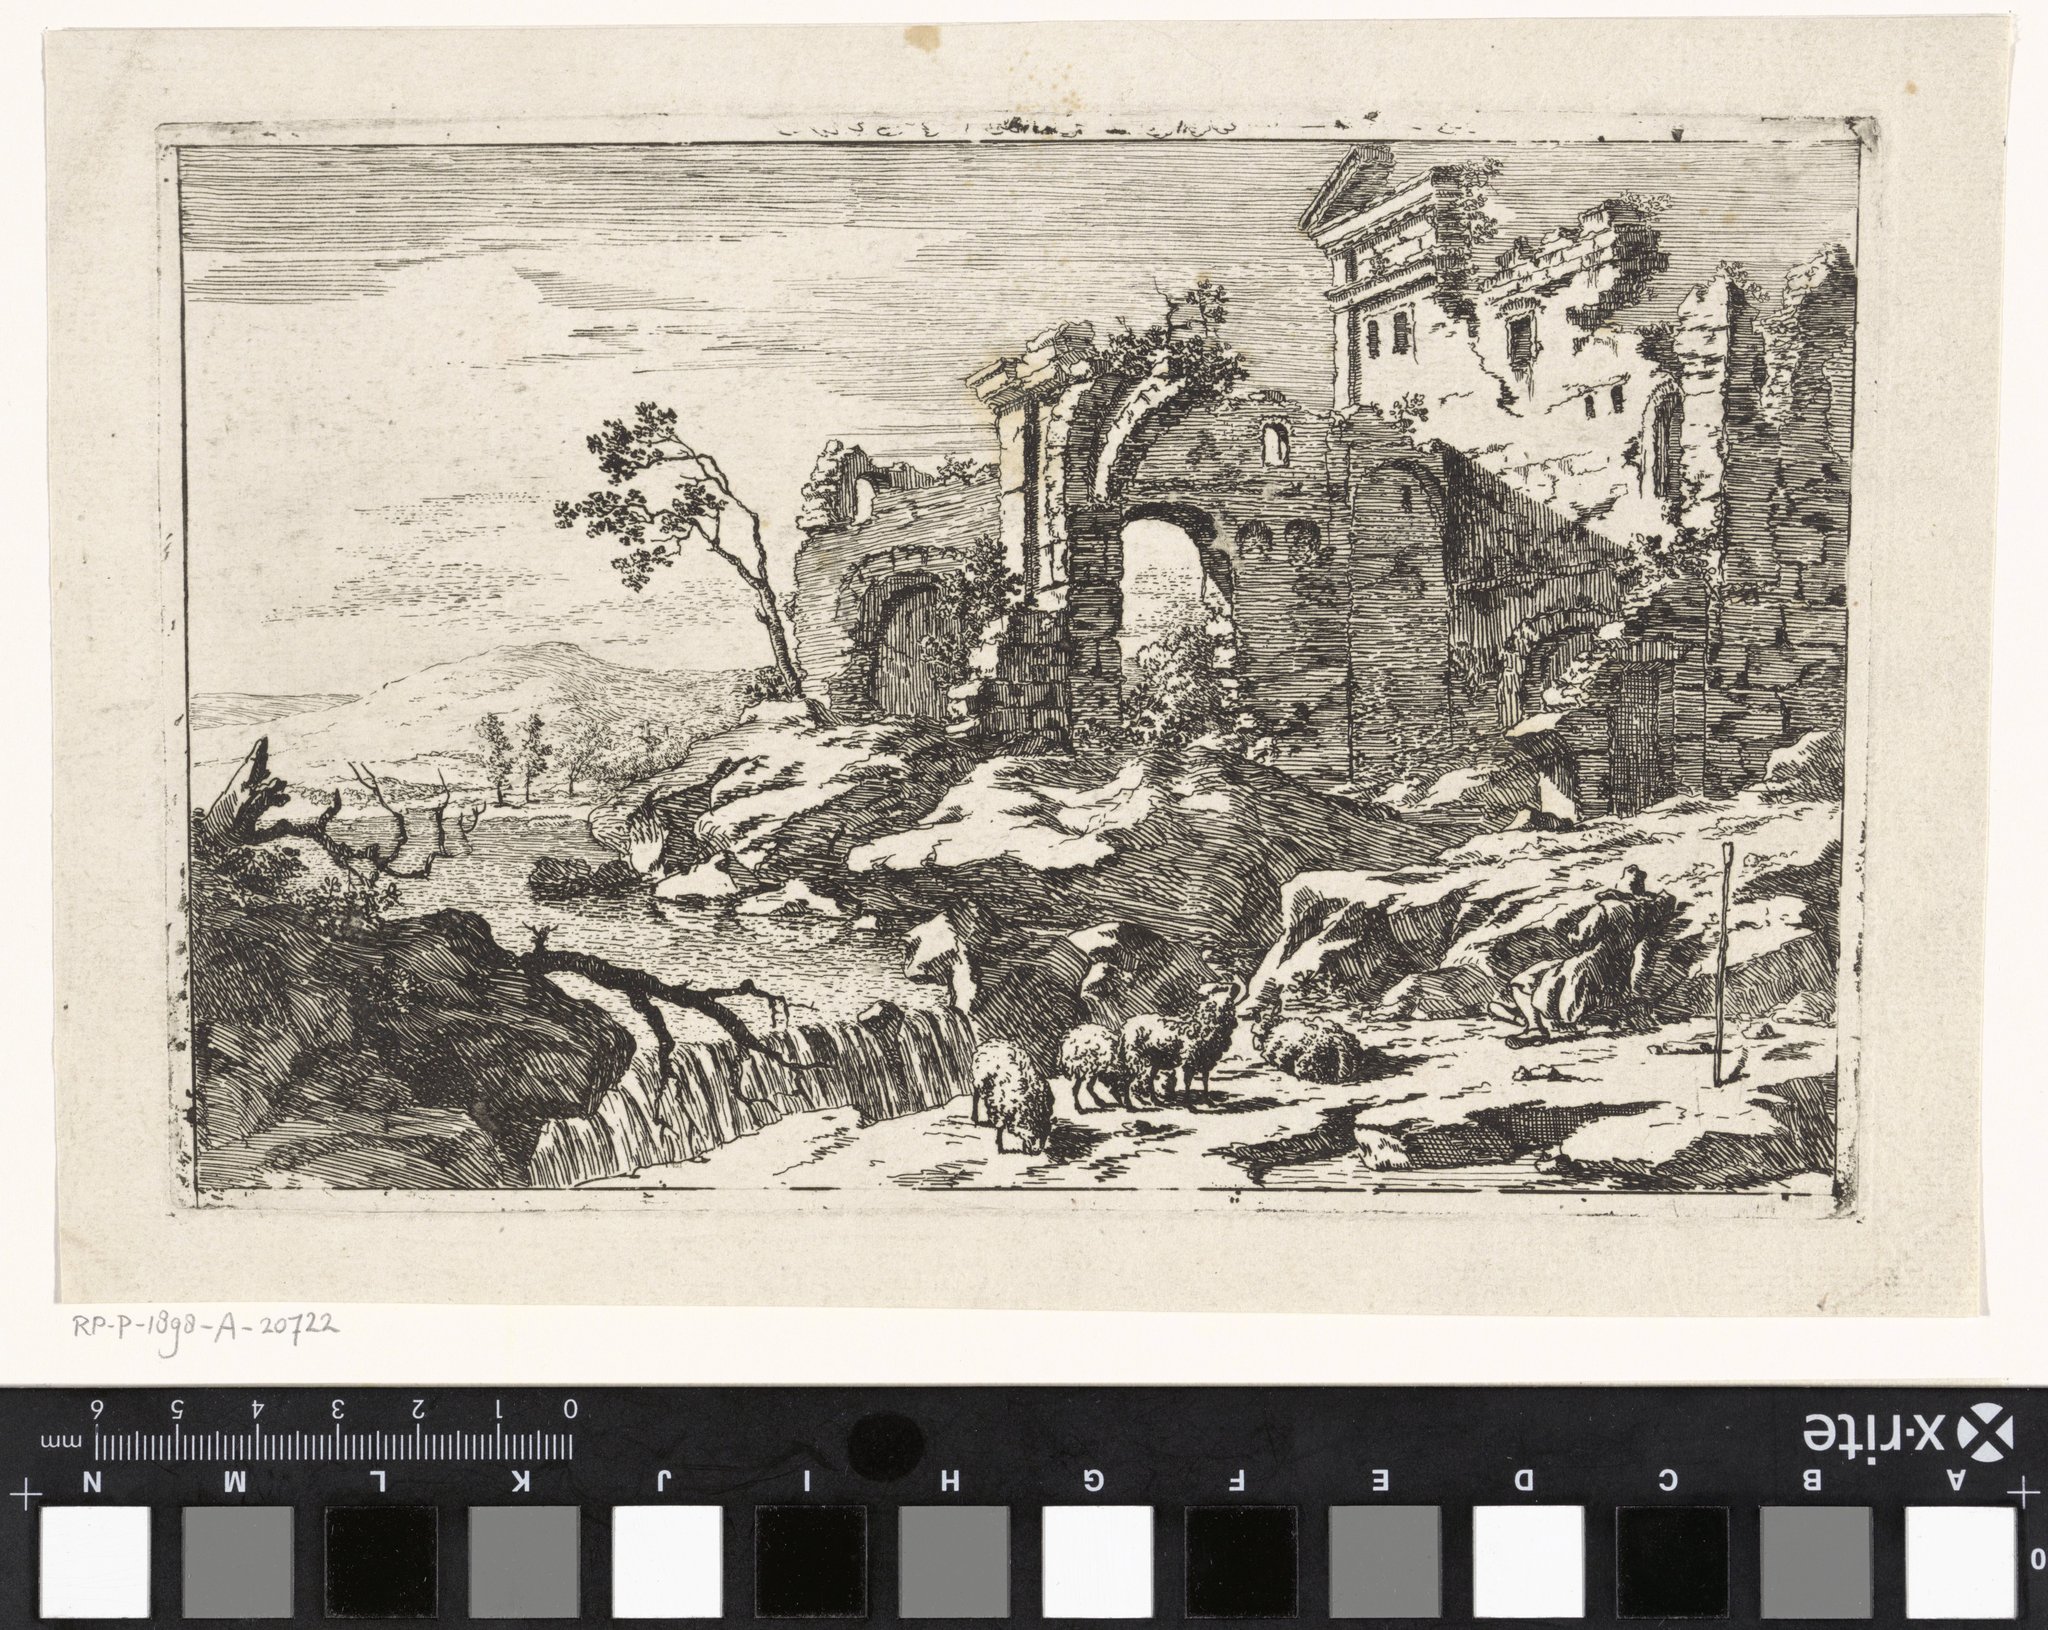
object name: print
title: Landschap met ruïne en waterval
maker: jan smees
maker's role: draughtsman, print maker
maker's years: 1670-1729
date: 1705-1729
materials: paper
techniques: etching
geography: amsterdam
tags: waterfall, landscape with ruins - ii - ideal landscapes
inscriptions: collector's mark: Lugt 964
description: Landschap met een ruïne van een gebouw met boogconstructies. Op de voorgrond zit een herder met een kudde schapen. Daarachter een waterval.